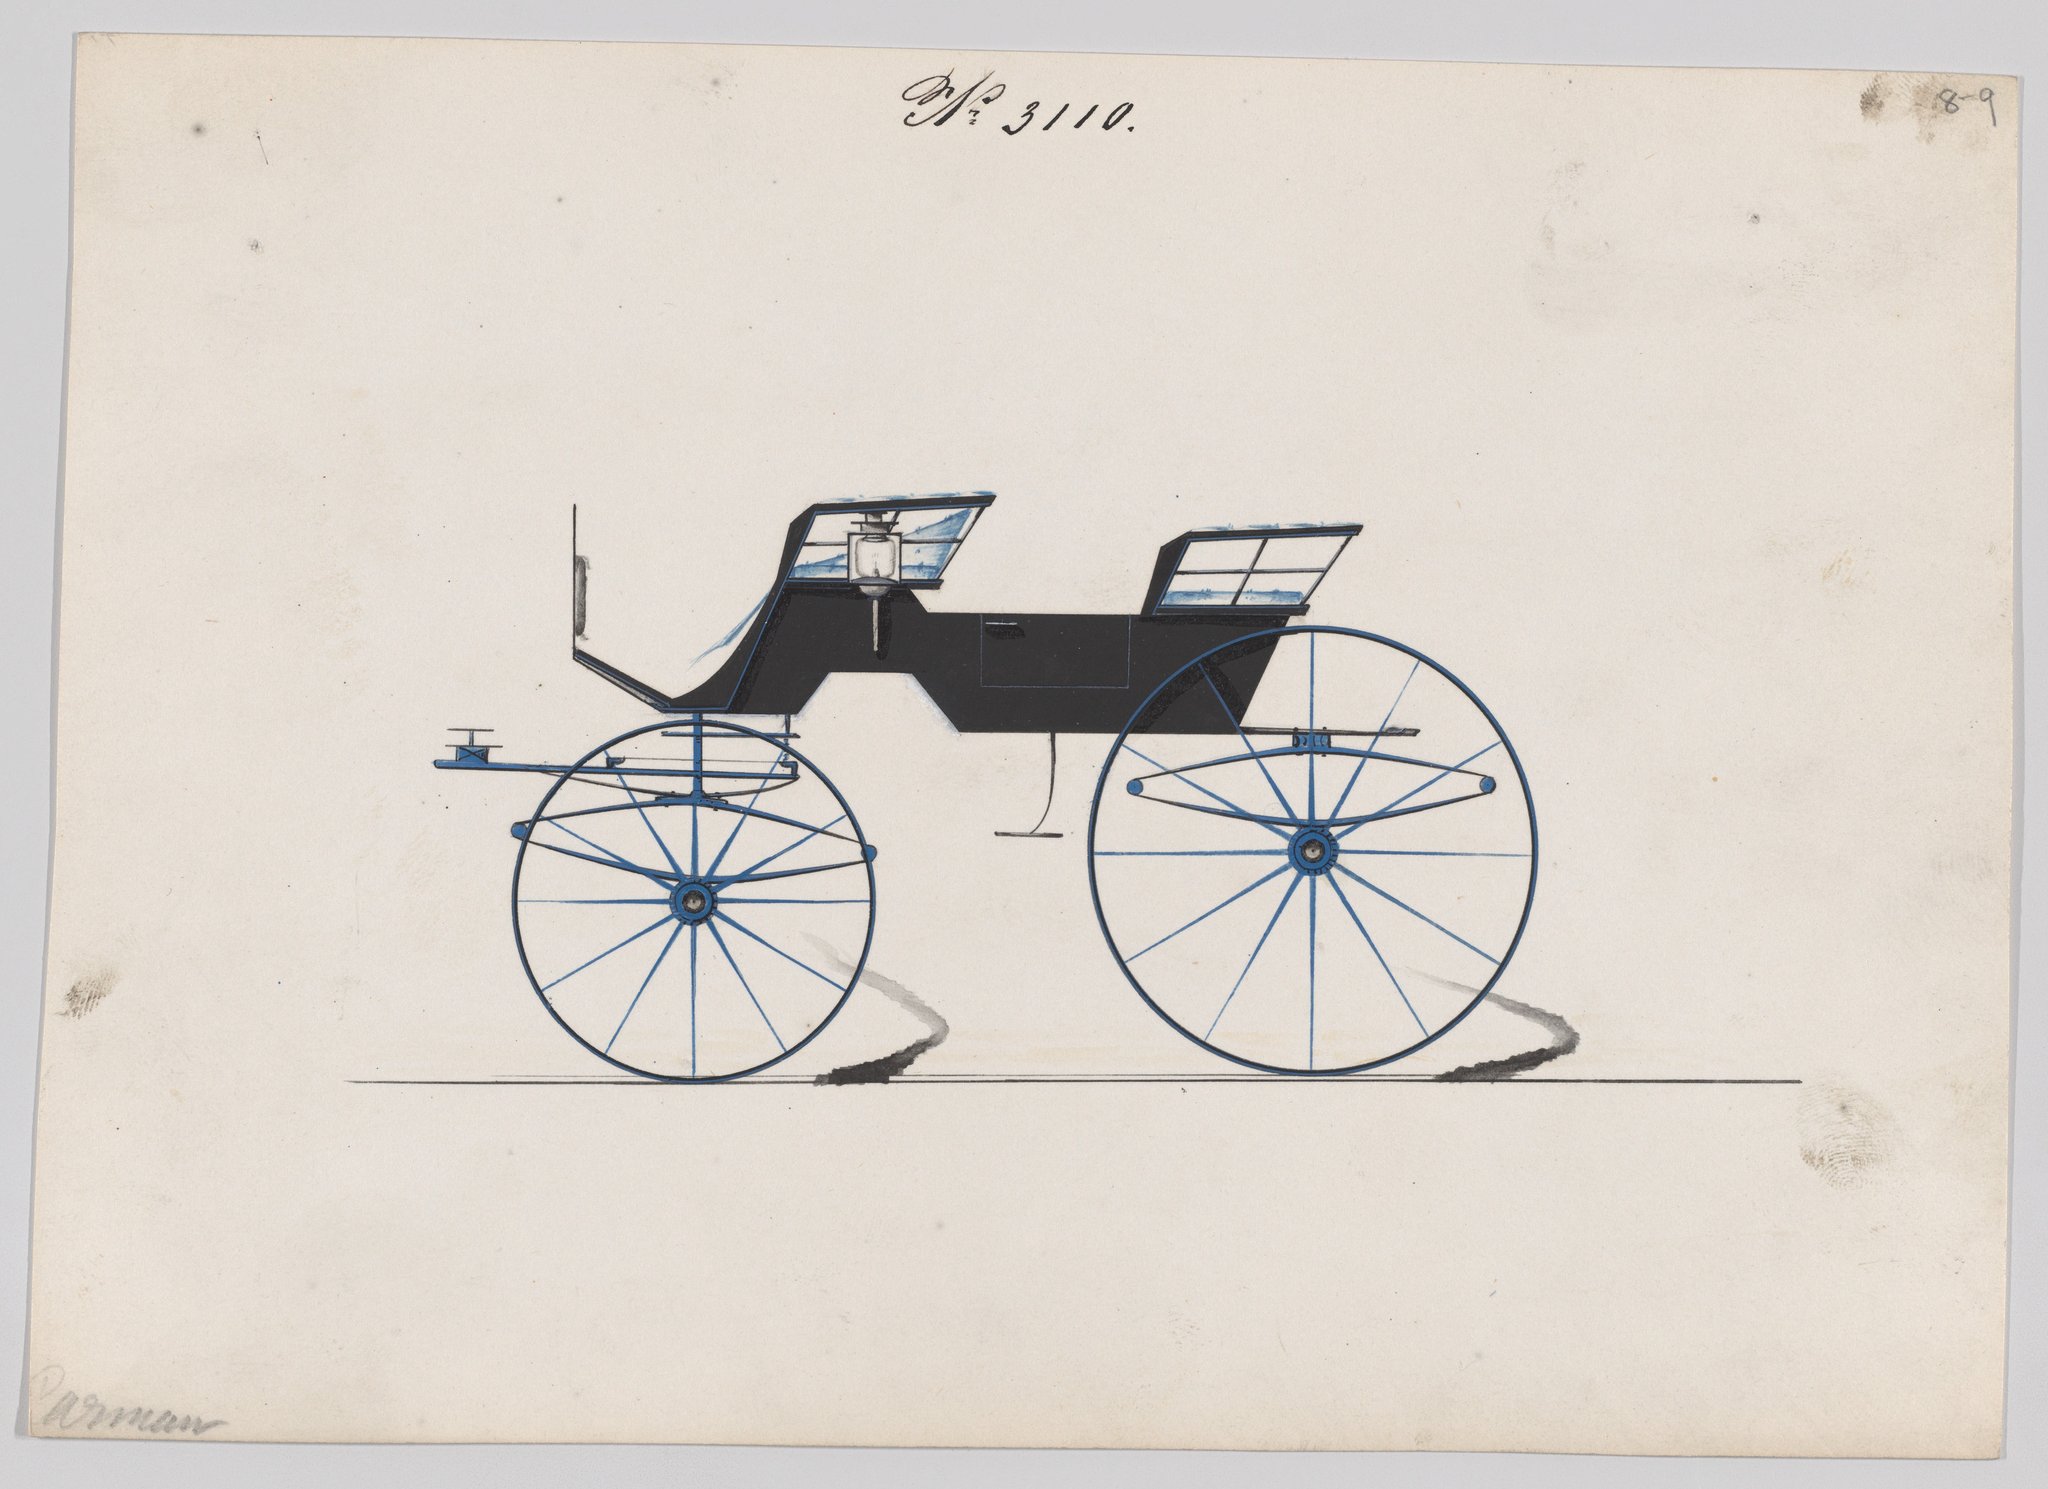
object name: drawing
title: Design for 4 seat Phaeton, no top, no. 3110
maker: brewster & co.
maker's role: manufacturer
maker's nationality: american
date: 1875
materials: gouache, ink, watercolor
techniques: pen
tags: carriages